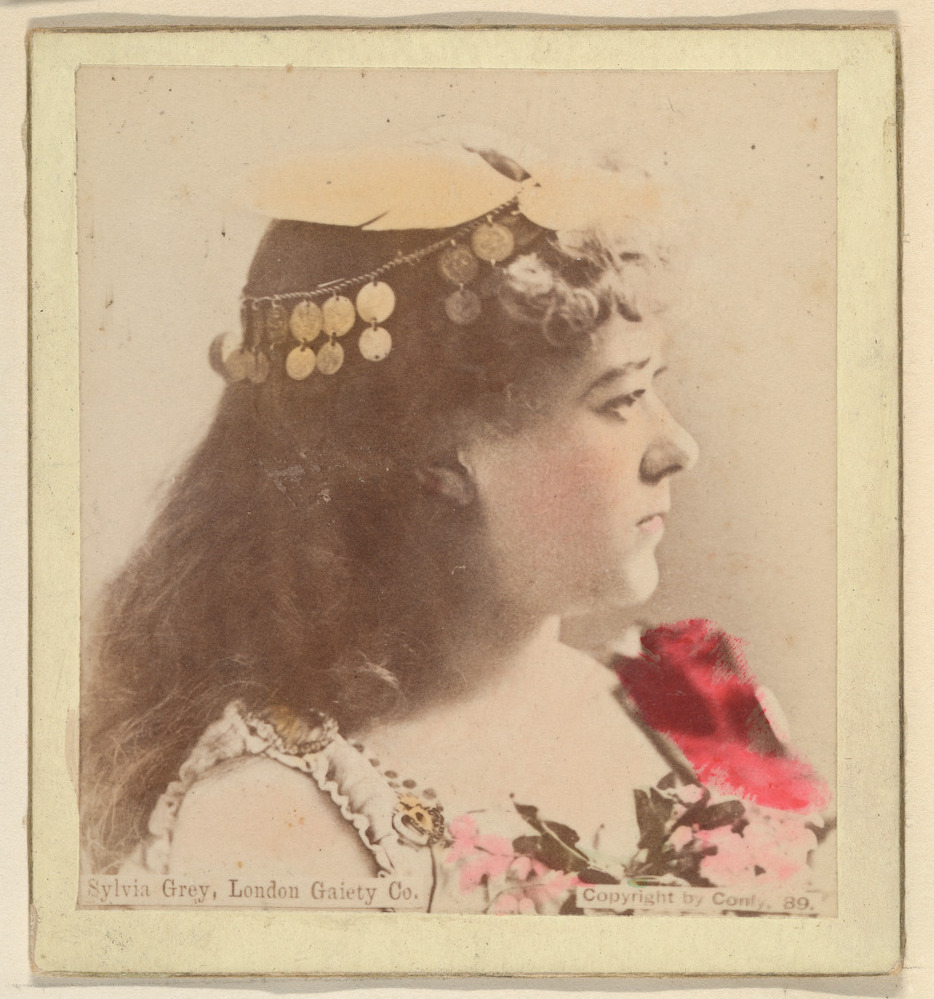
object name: photograph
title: Sylvia Grey, London Gaiety Co., from the Actresses series (N246), Type 2, issued by Kinney Brothers to promote Sporting Extra Cigarettes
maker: kinney brothers tobacco company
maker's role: publisher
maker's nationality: american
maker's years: 1869-2011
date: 1890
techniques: albumen silver print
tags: portraits,women,actresses